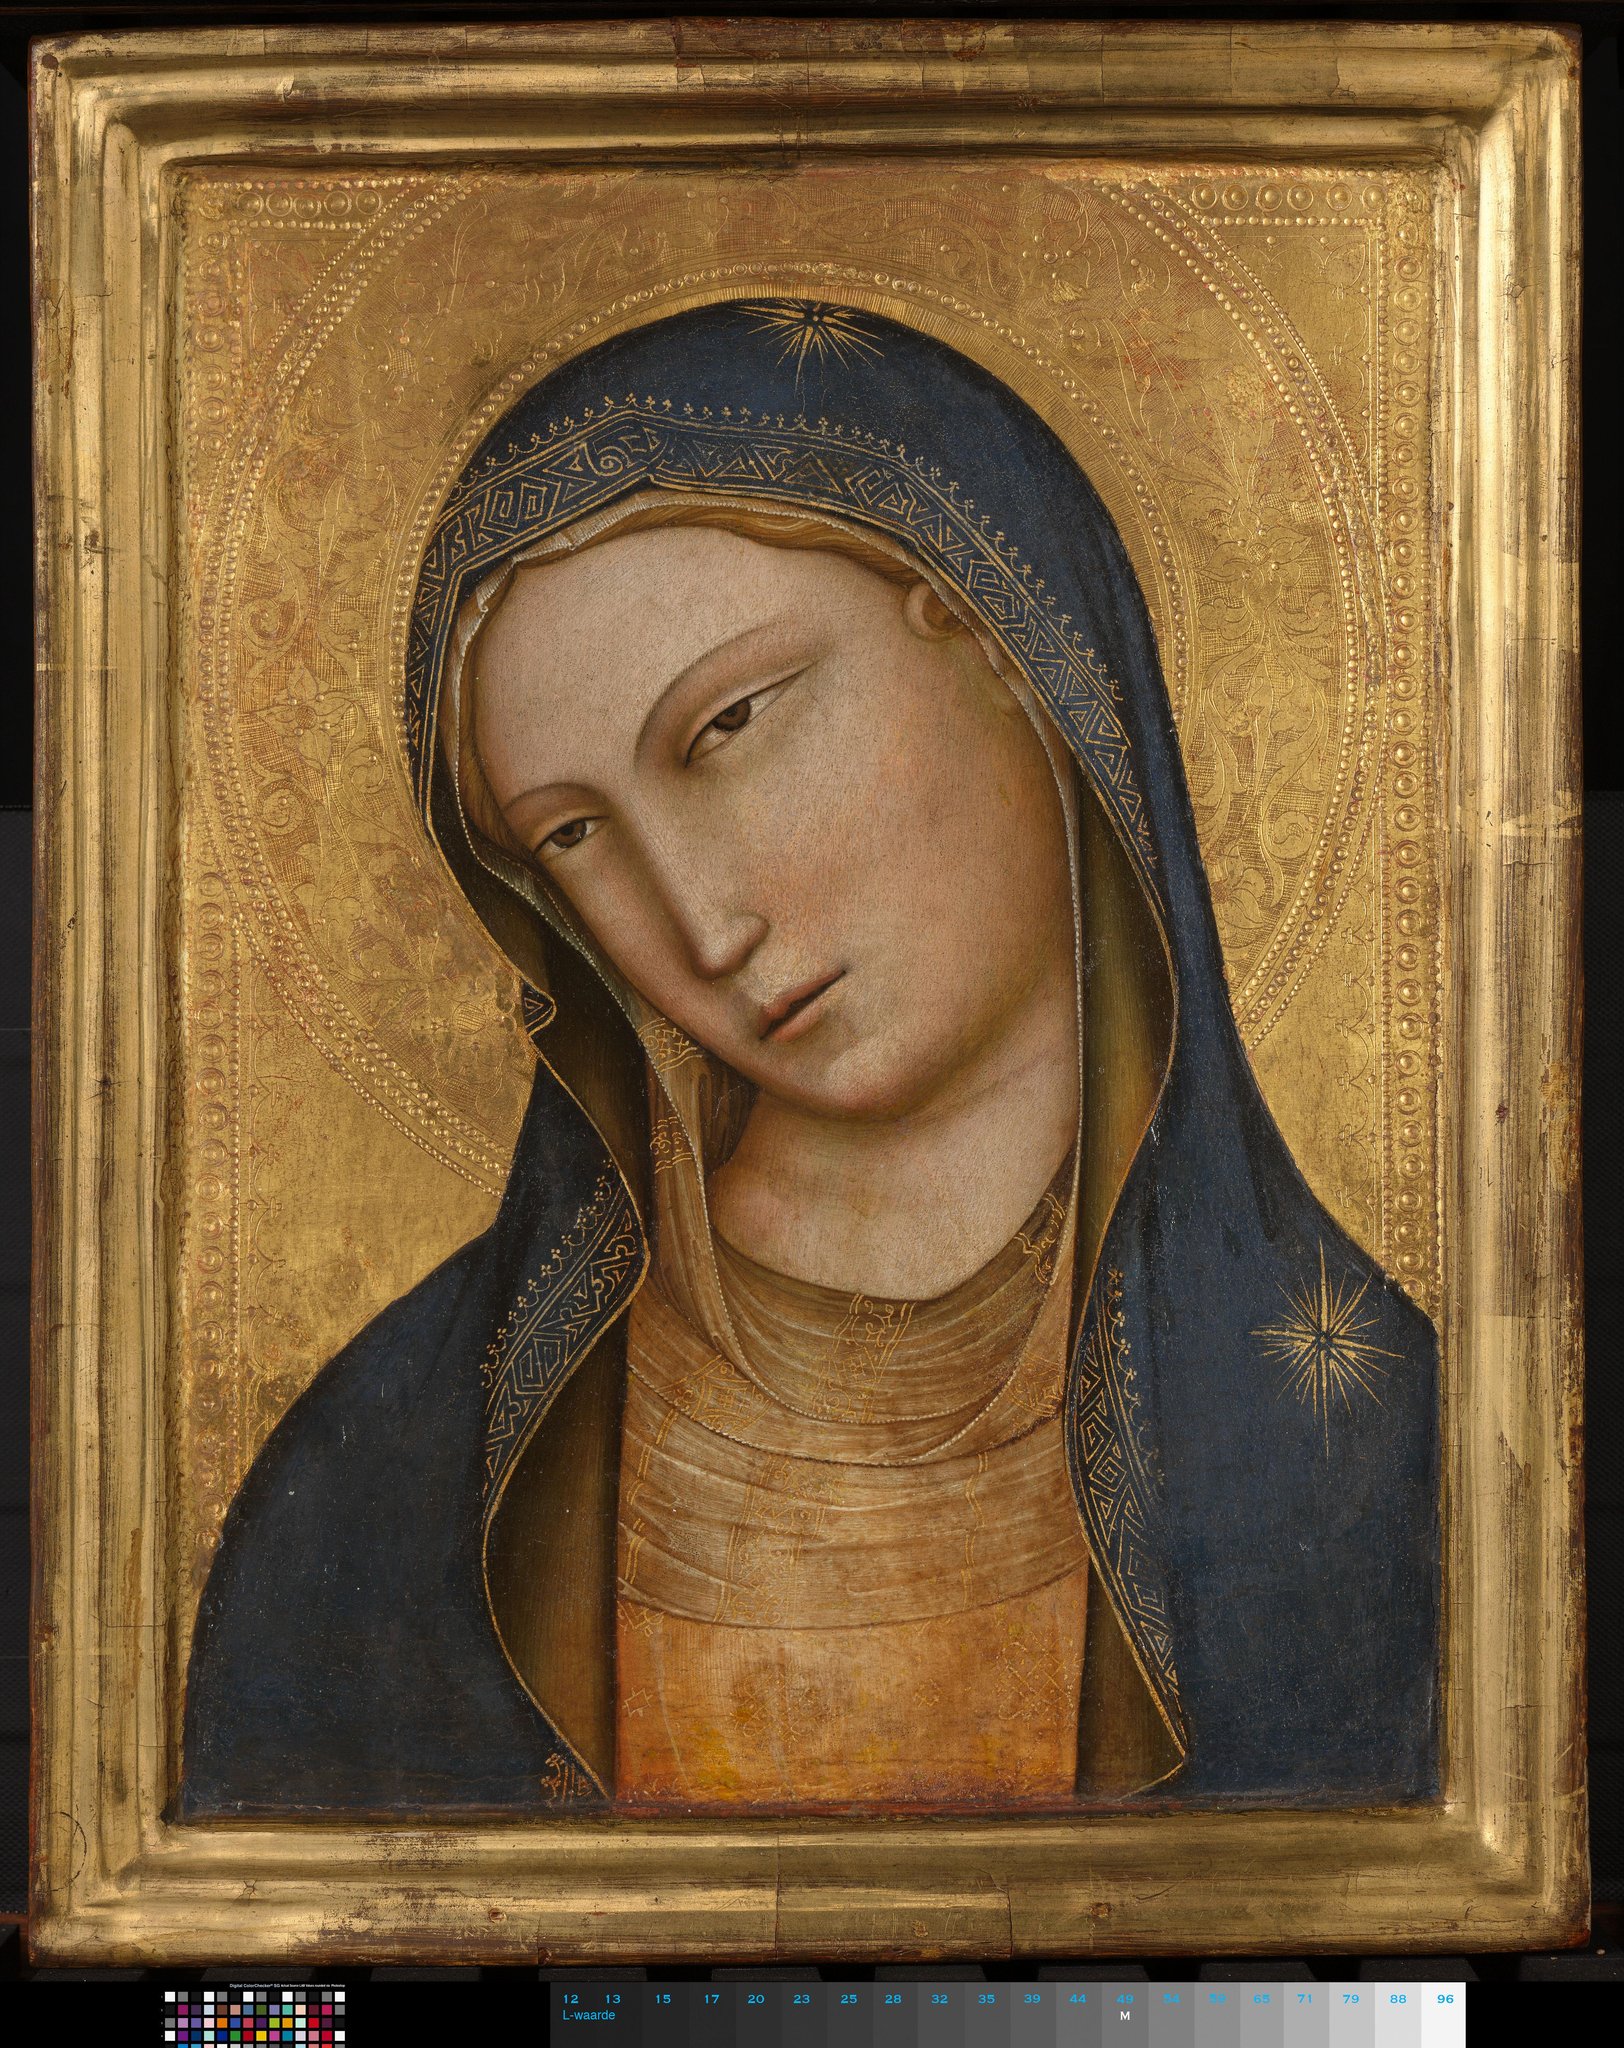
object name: painting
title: Bust of Saint Mary (formerly entitled Madonna)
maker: lorenzo monaco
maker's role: draughtsman, painter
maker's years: 1370-1425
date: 1381-1425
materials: panel, paint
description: Madonna. Buste van Maria, iets naar links gewend, tegen een gouden achtergrond. Met geïntegreerde lijst.